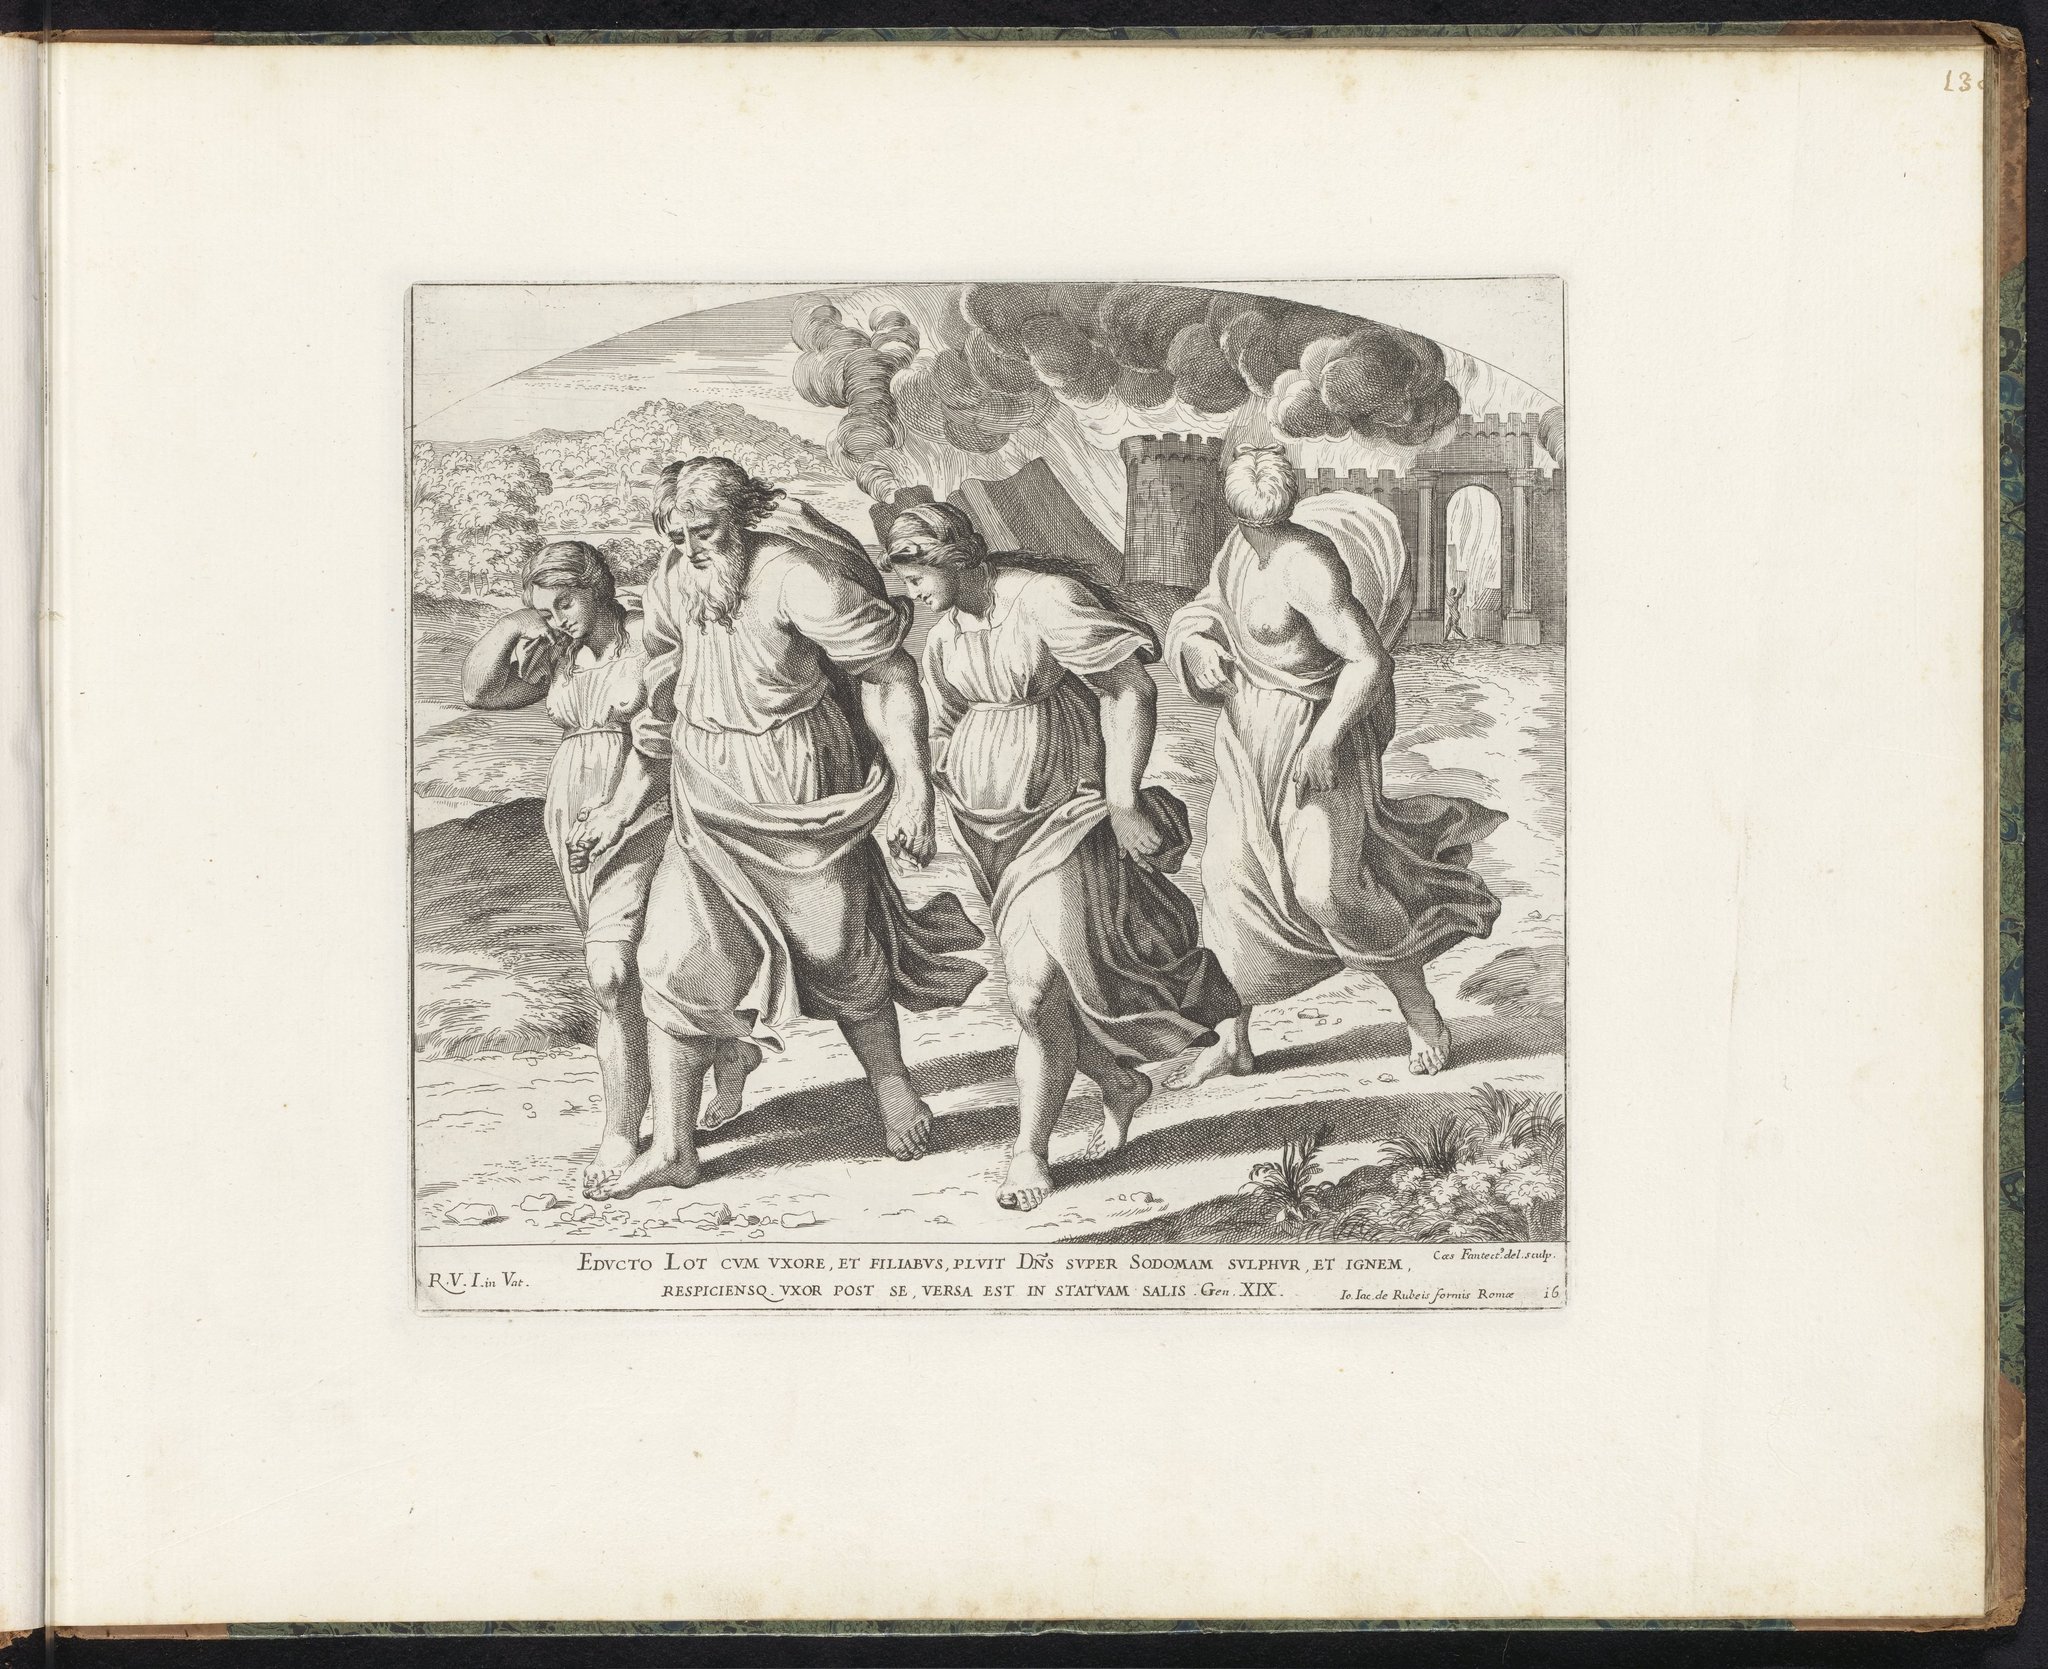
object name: print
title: Schilderingen in de Loggia van Rafaël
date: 1675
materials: paper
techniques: etching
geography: rome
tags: the destruction of sodom and gomorrah: lot and his family flee to zoar, carrying their belongings; an angel may be showing the way (genesis 19:24-29)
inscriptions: number: ‘138’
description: Prent maakt deel uit van een reeks van 55 prenten, bestaande uit drie ongenummerde prenten en een set van 52 genummerde prenten naar de schilderingen in de Loggia van Rafaël.